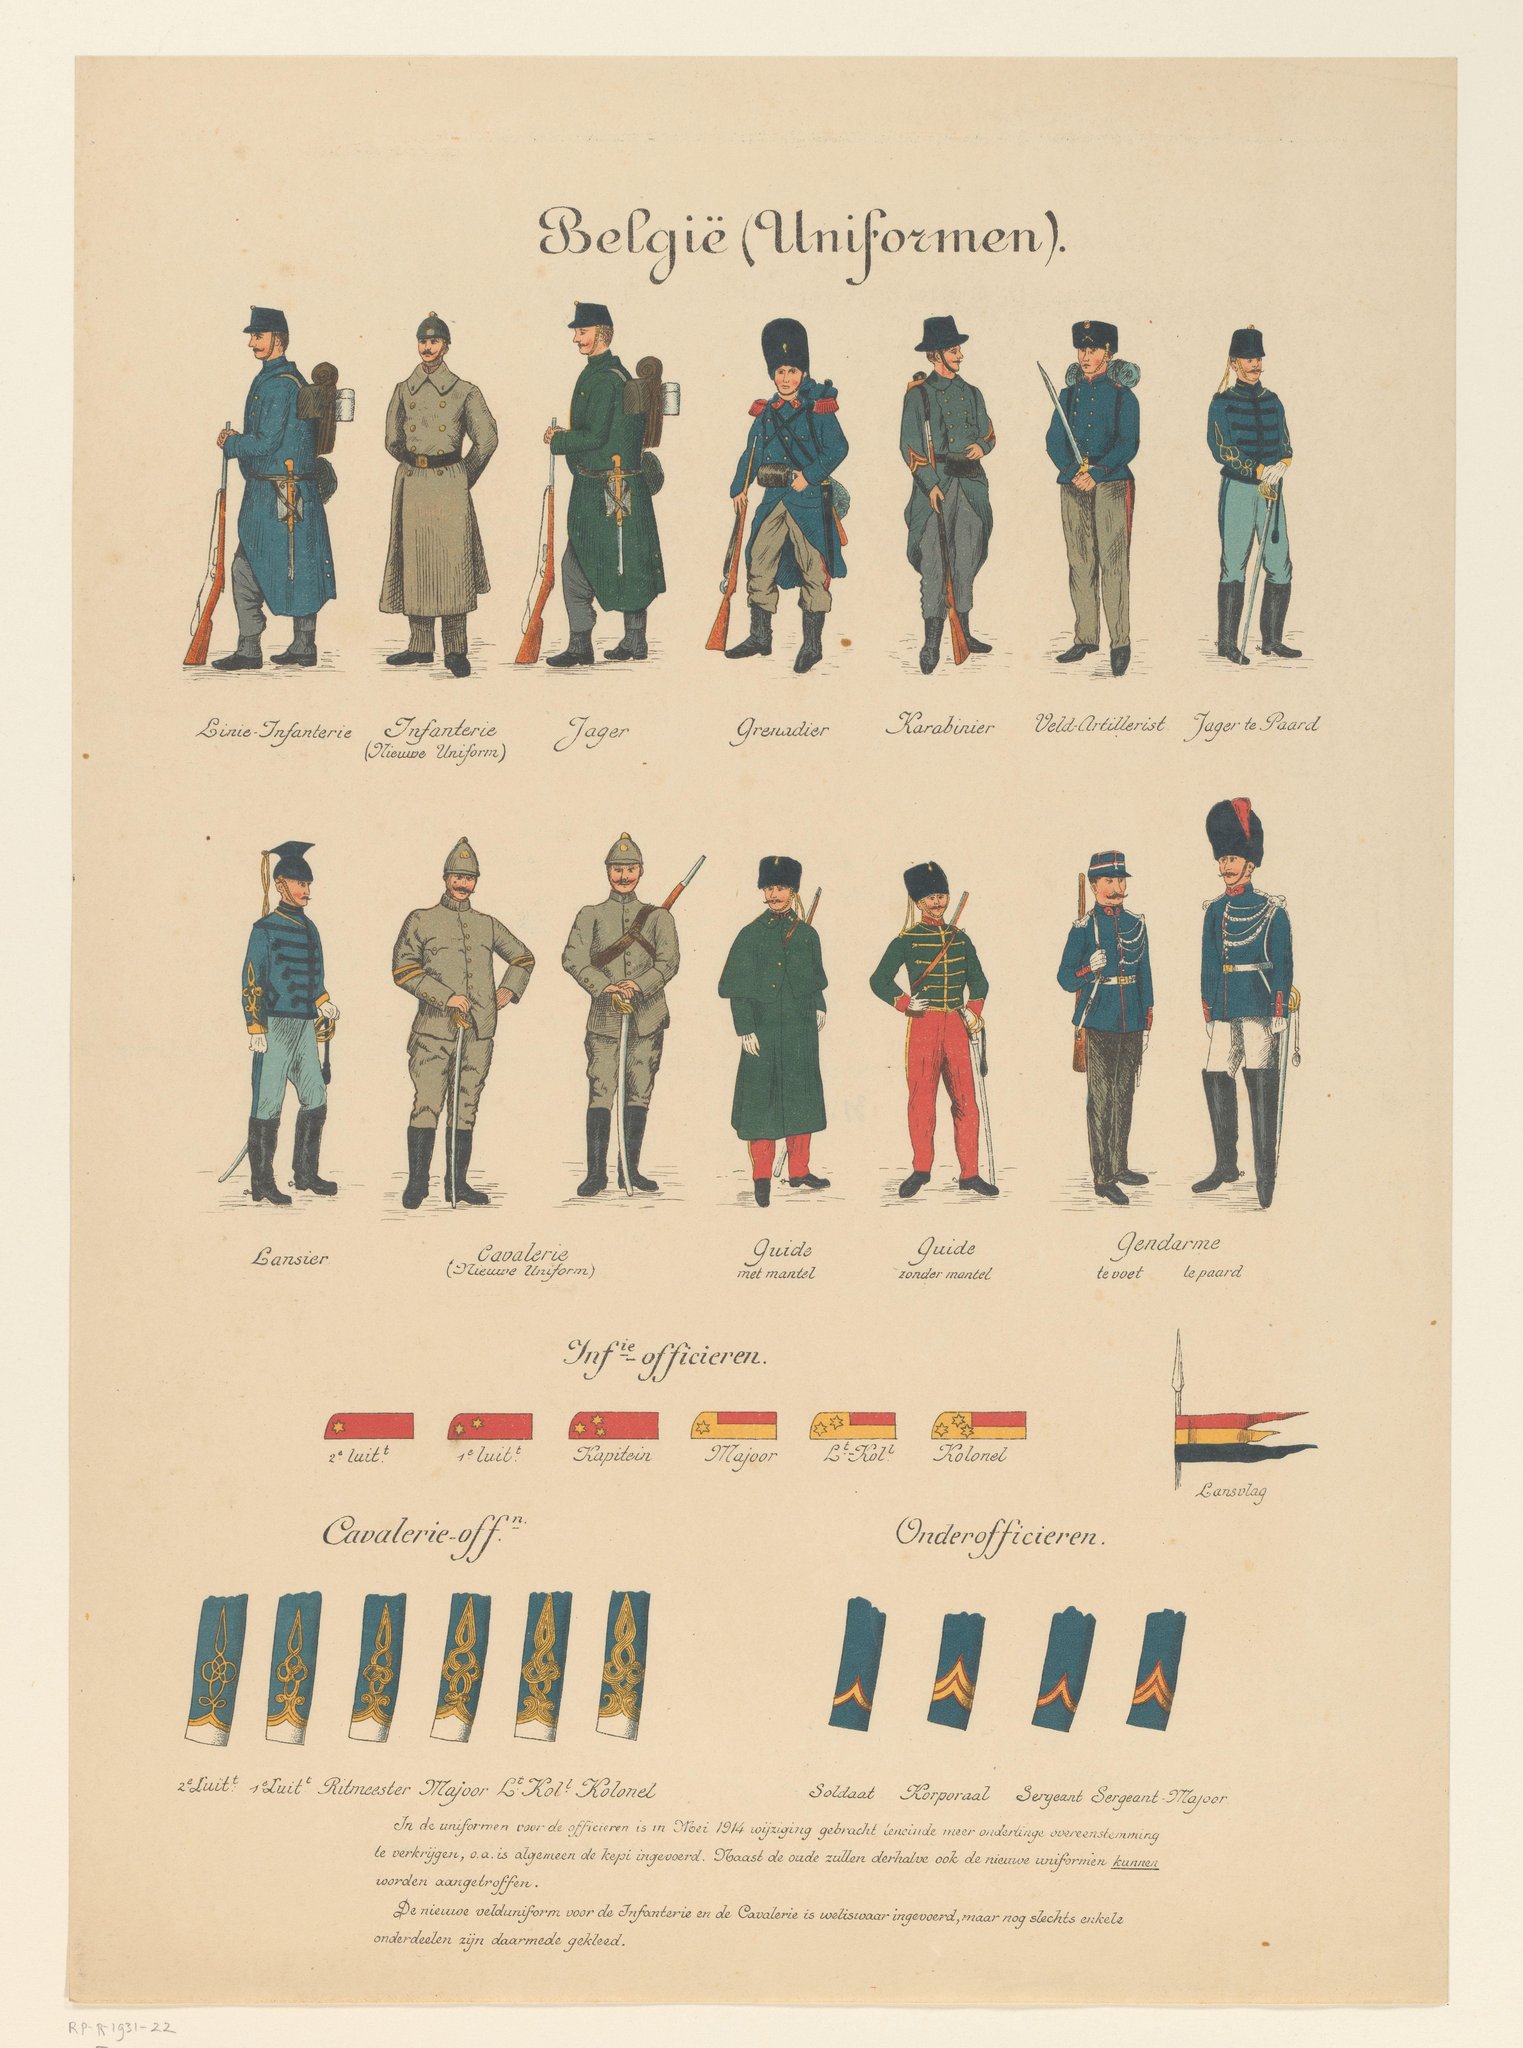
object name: print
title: België (Uniformen)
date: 1914-1918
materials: paper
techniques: color autotype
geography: netherlands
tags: (military) uniforms, belgium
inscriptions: collector's mark: Lugt 2228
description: Overzicht van uniformen van het Belgische leger tijdens de Eerste Wereldoorlog.